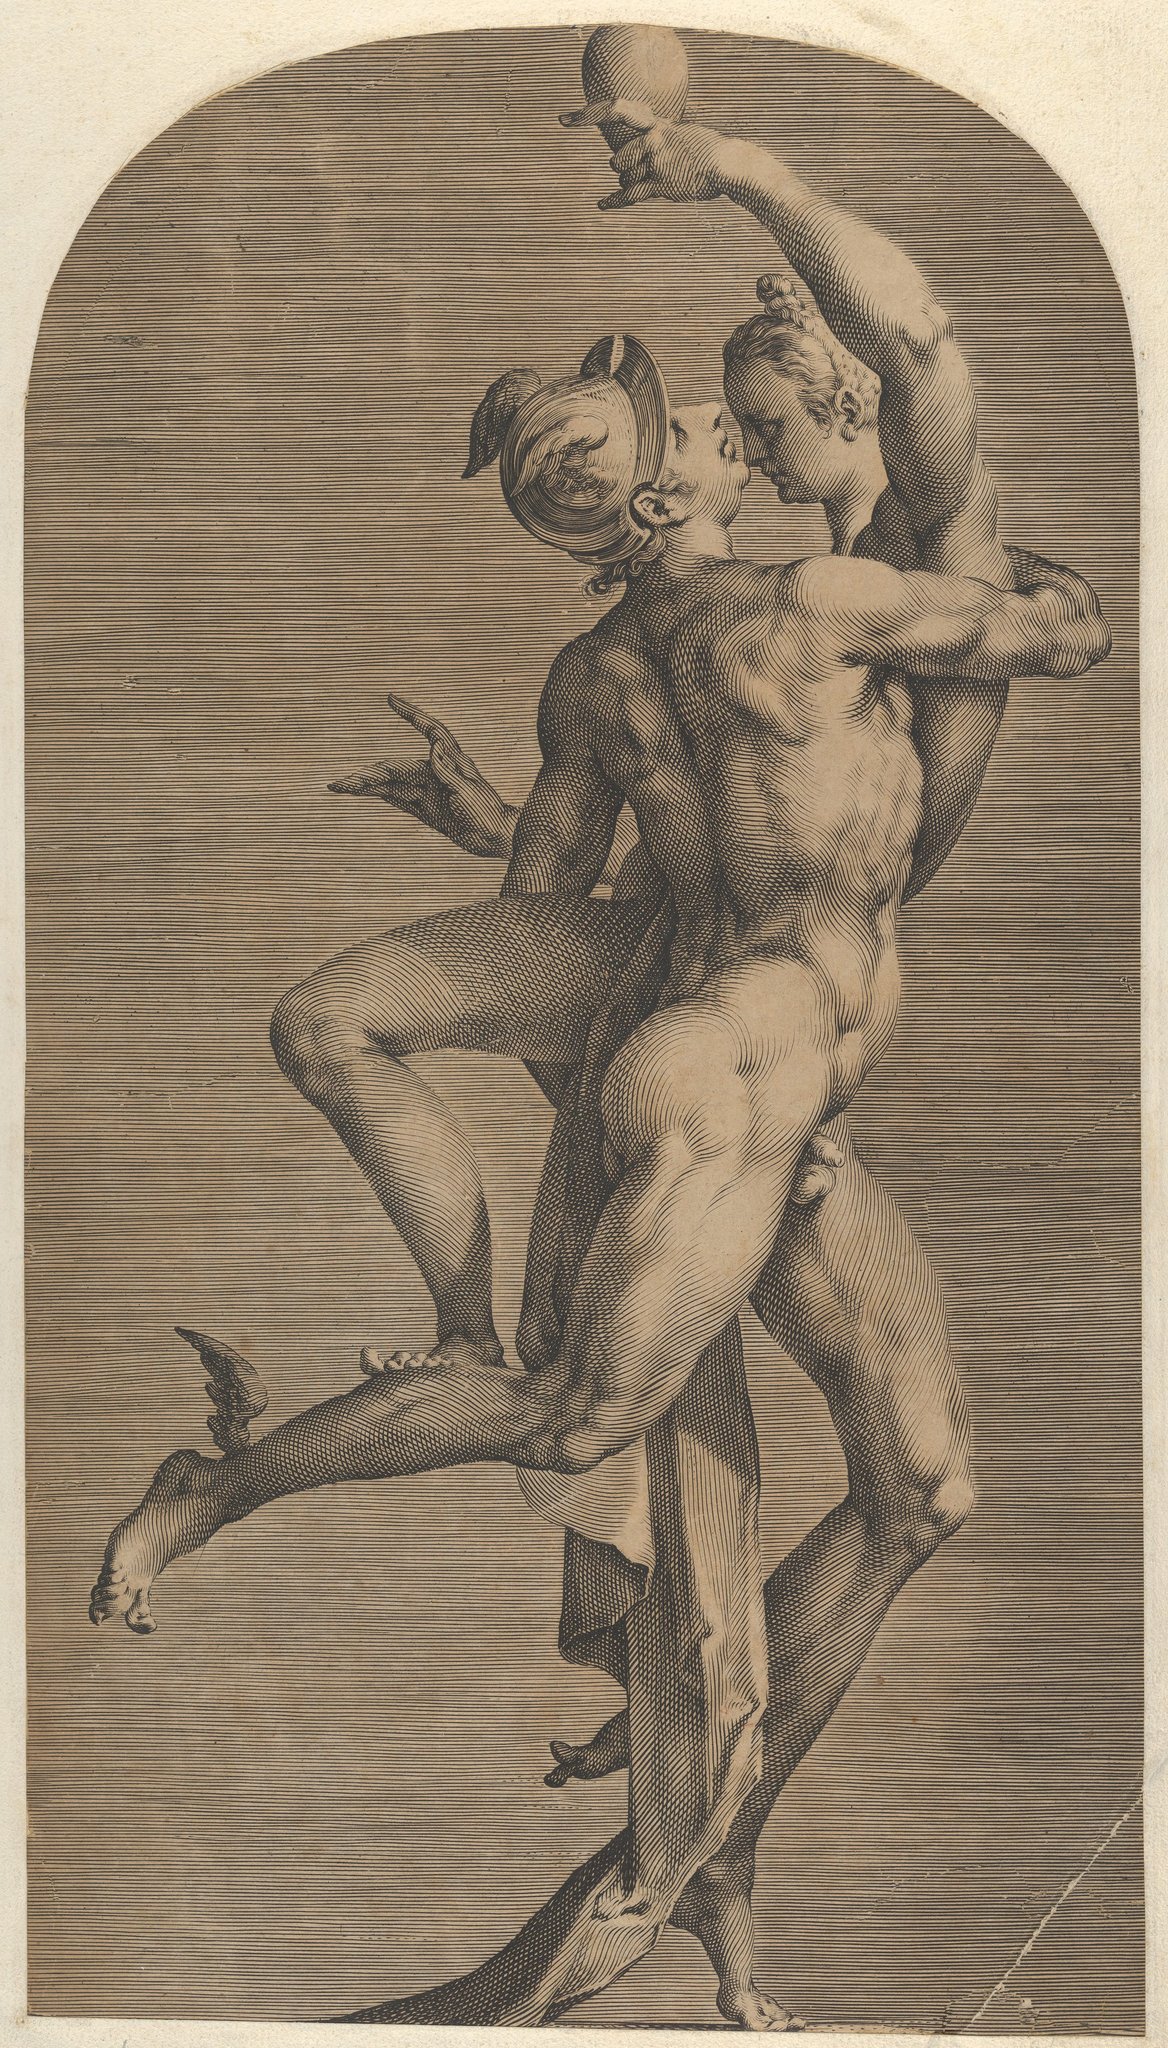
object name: print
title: Mercury Abducting Psyche (lateral view Mercury's side), from a set of three views of the sculpture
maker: jan muller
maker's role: artist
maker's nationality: netherlandish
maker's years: 1571-1628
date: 1593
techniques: engraving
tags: psyche,mercury